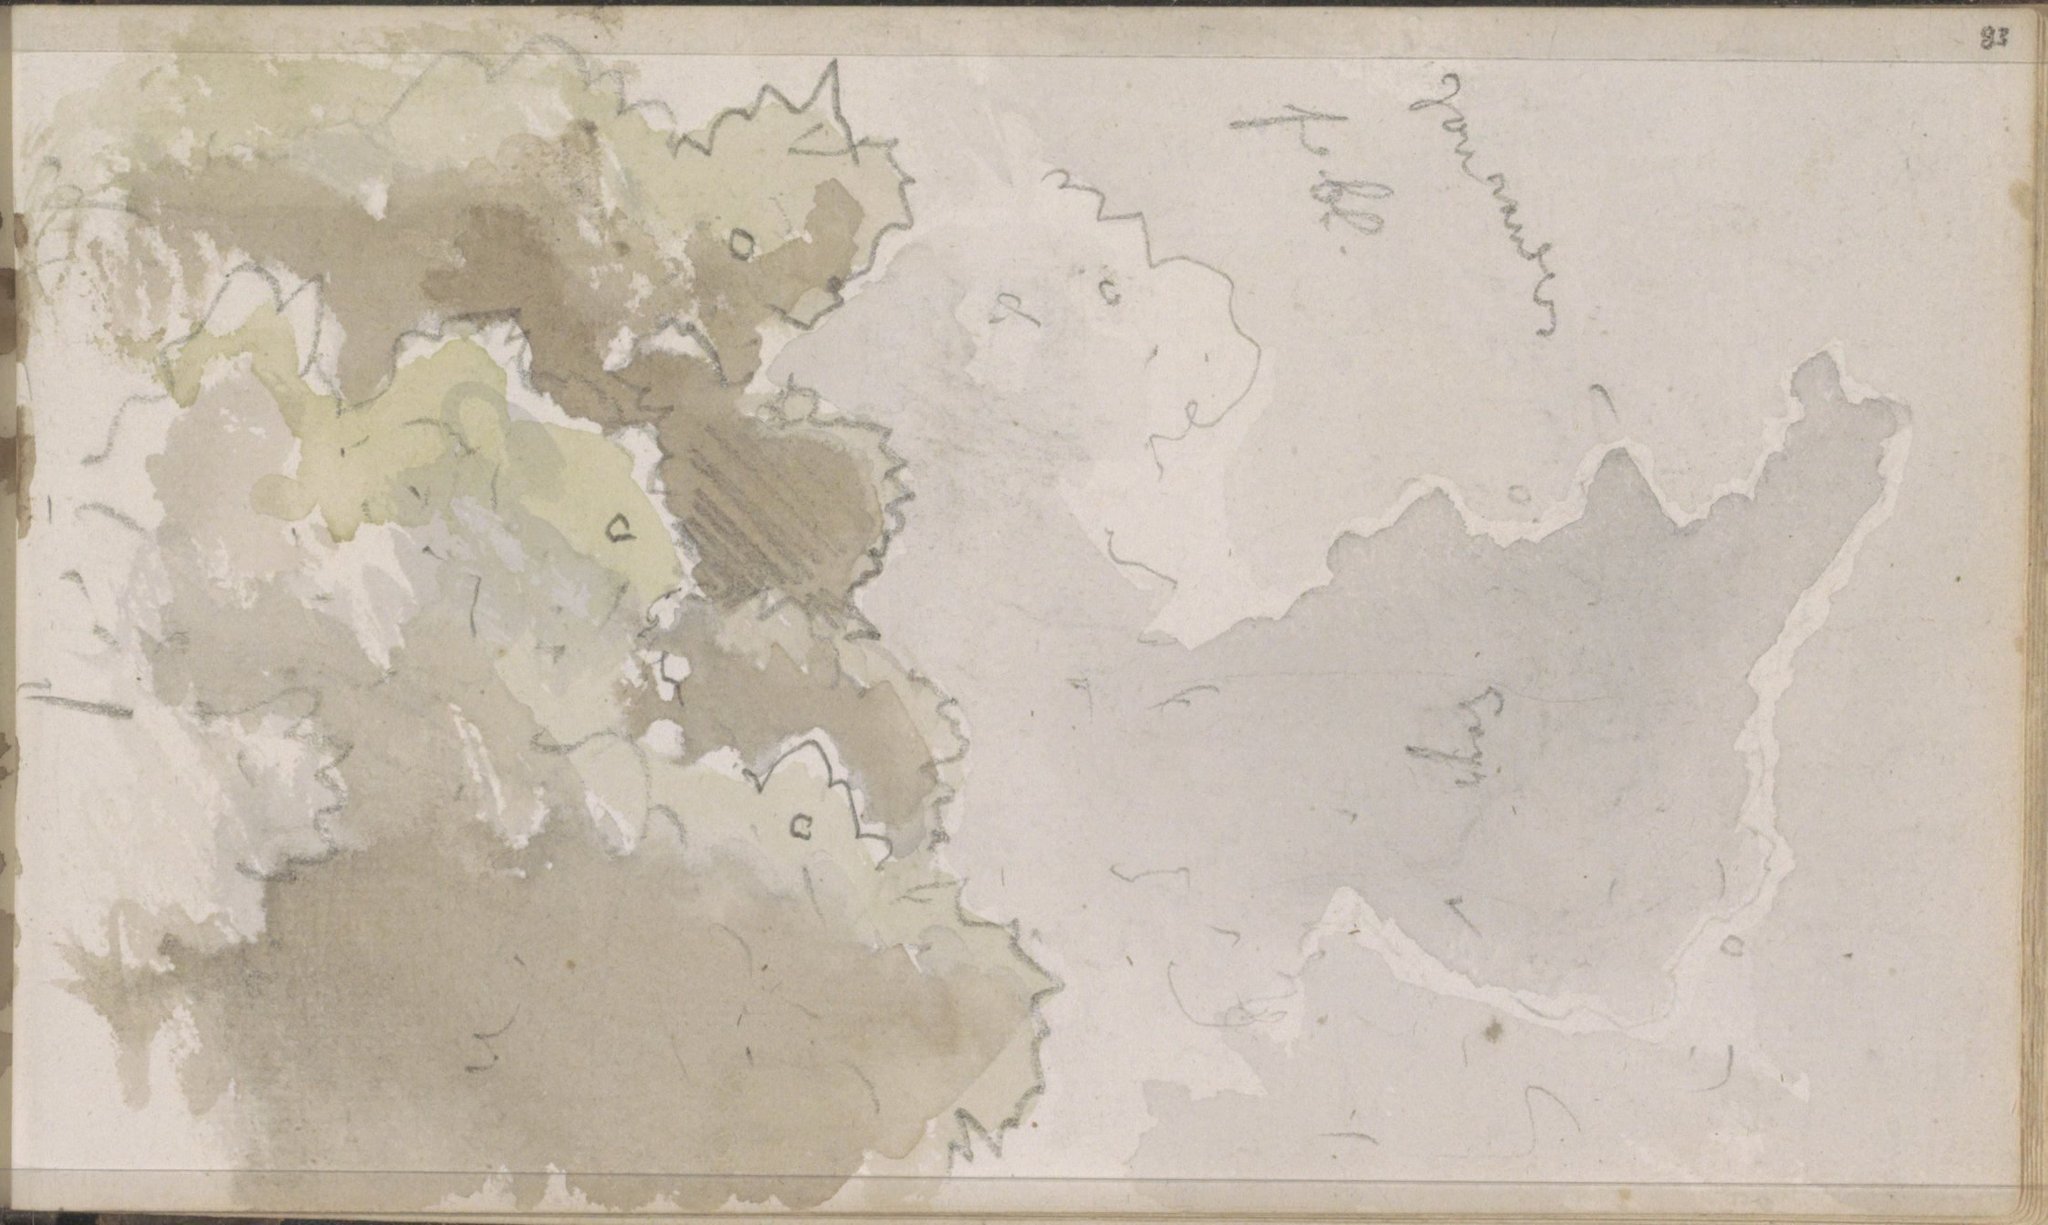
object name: sketchbook leaf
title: Wolkenlucht boven enkele boomtoppen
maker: johannes tavenraat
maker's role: draughtsman, painter, print maker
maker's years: 1809-1881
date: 1864-1880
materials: paper, pencil, watercolor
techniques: brush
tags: trees, landscapes, clouds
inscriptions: kleurnotitie, handgeschreven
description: Blad 83 recto uit een schetsboek met 98 bladen.